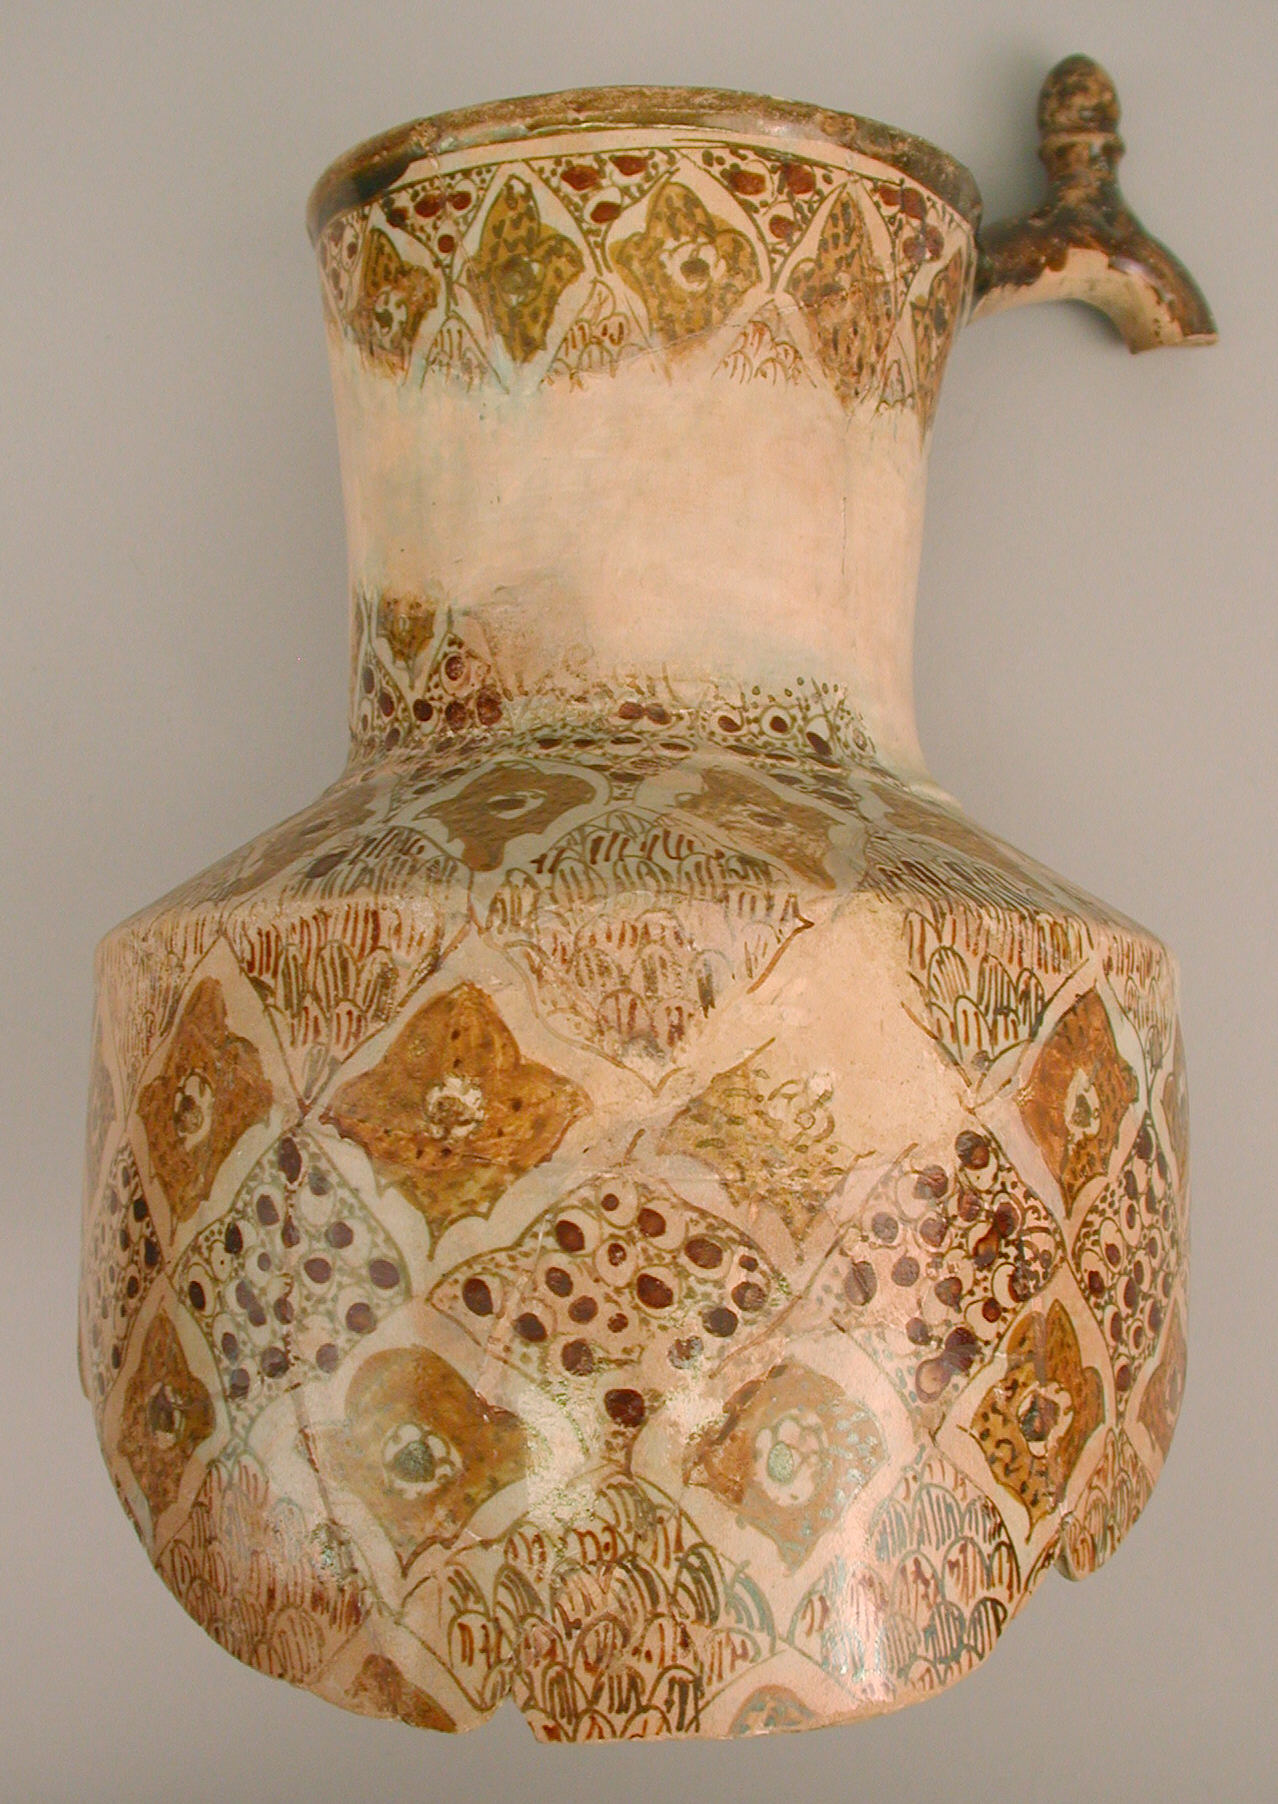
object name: ewer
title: Fragmentary Ewer with Polychrome Luster Decoration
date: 801-900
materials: earthenware, glaze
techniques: luster painting, polychrome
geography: iraq